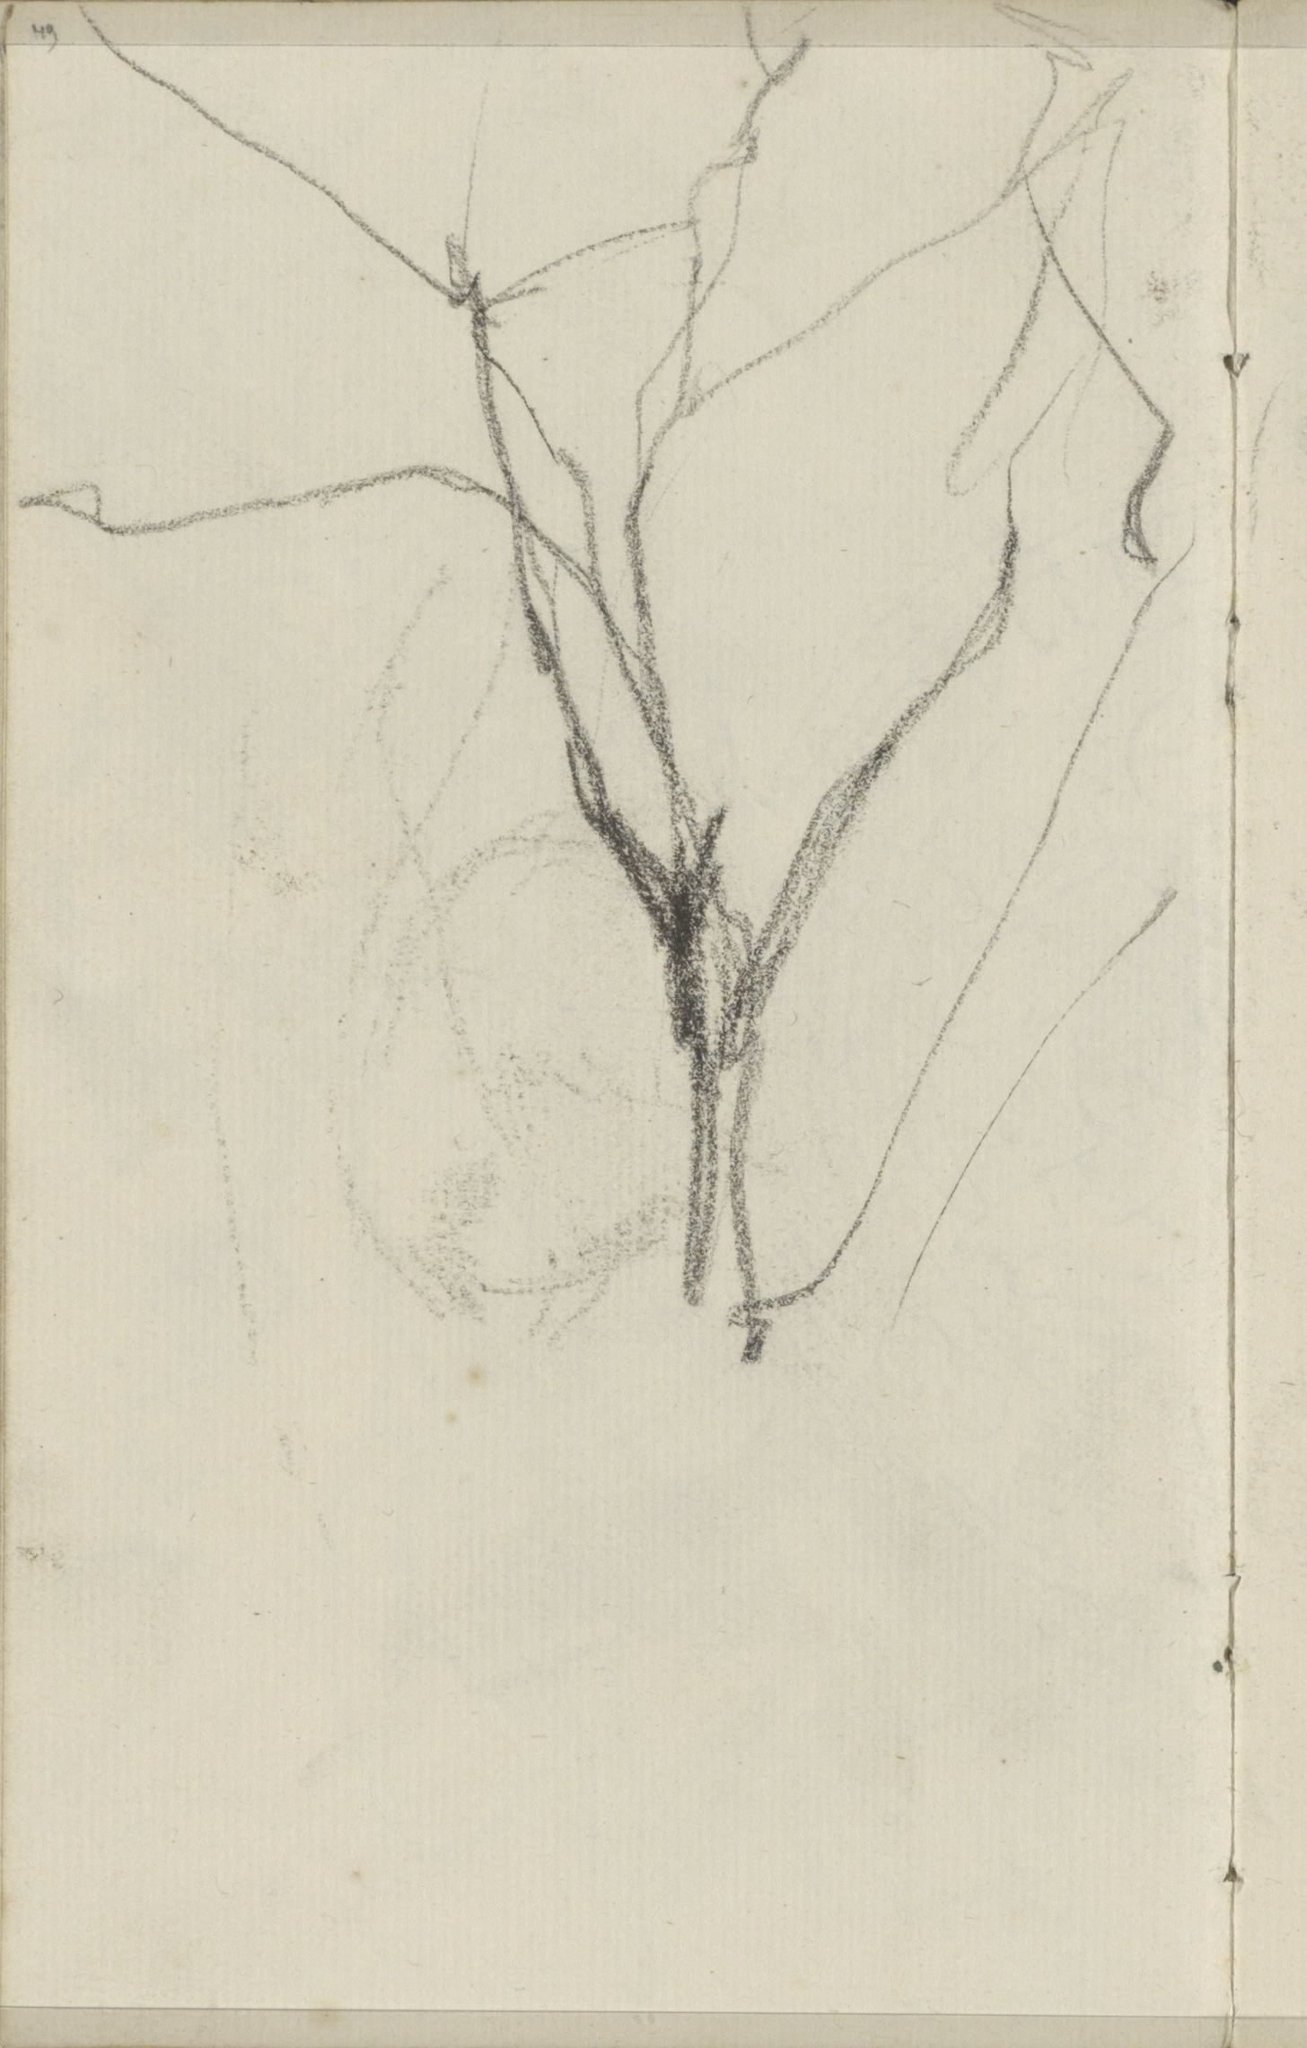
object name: sketchbook leaf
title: Boom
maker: george hendrik breitner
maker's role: draughtsman, painter, print maker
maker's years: 1857-1923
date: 1880-1882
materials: chalk, paper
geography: scheveningen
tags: trees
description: Pagina 49 uit een schetsboek met 31 bladen.